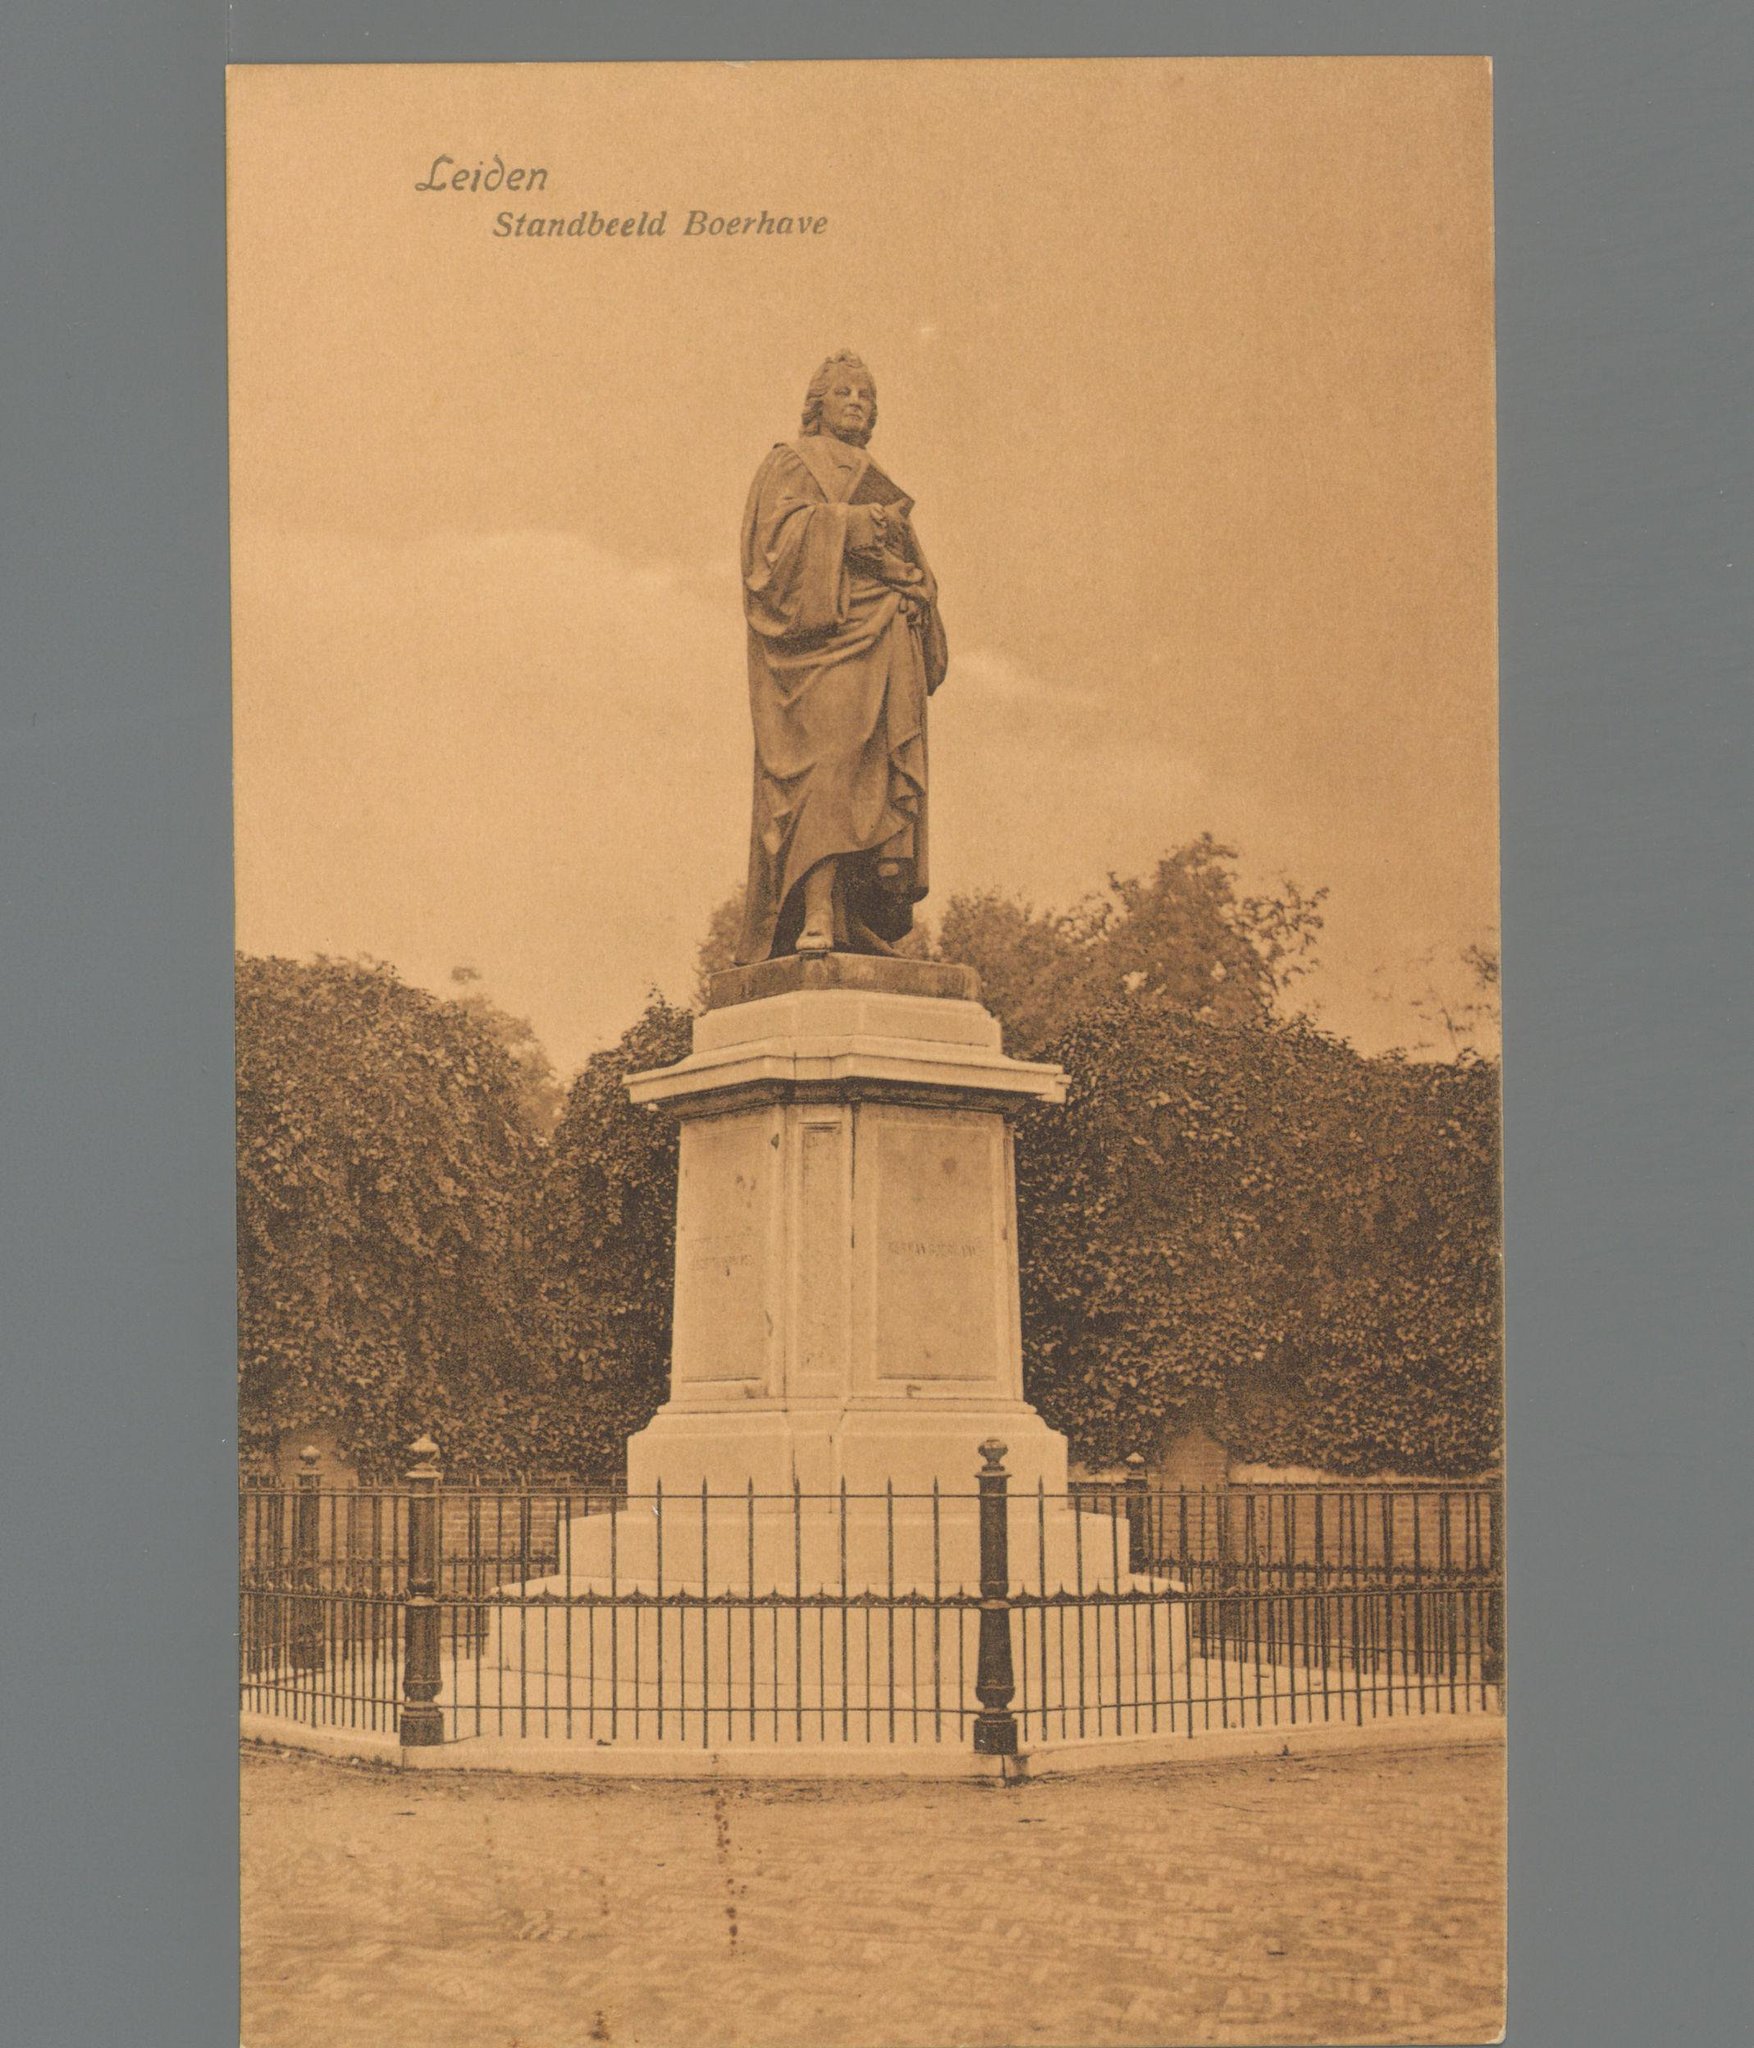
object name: ansichtkaart, prentbriefkaart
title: Leiden. Standbeeld Boerhave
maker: Anonymous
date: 1910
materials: cardboard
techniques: photograph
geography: leipzig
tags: leiden, hermanus boerhaave, monument, statue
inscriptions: date